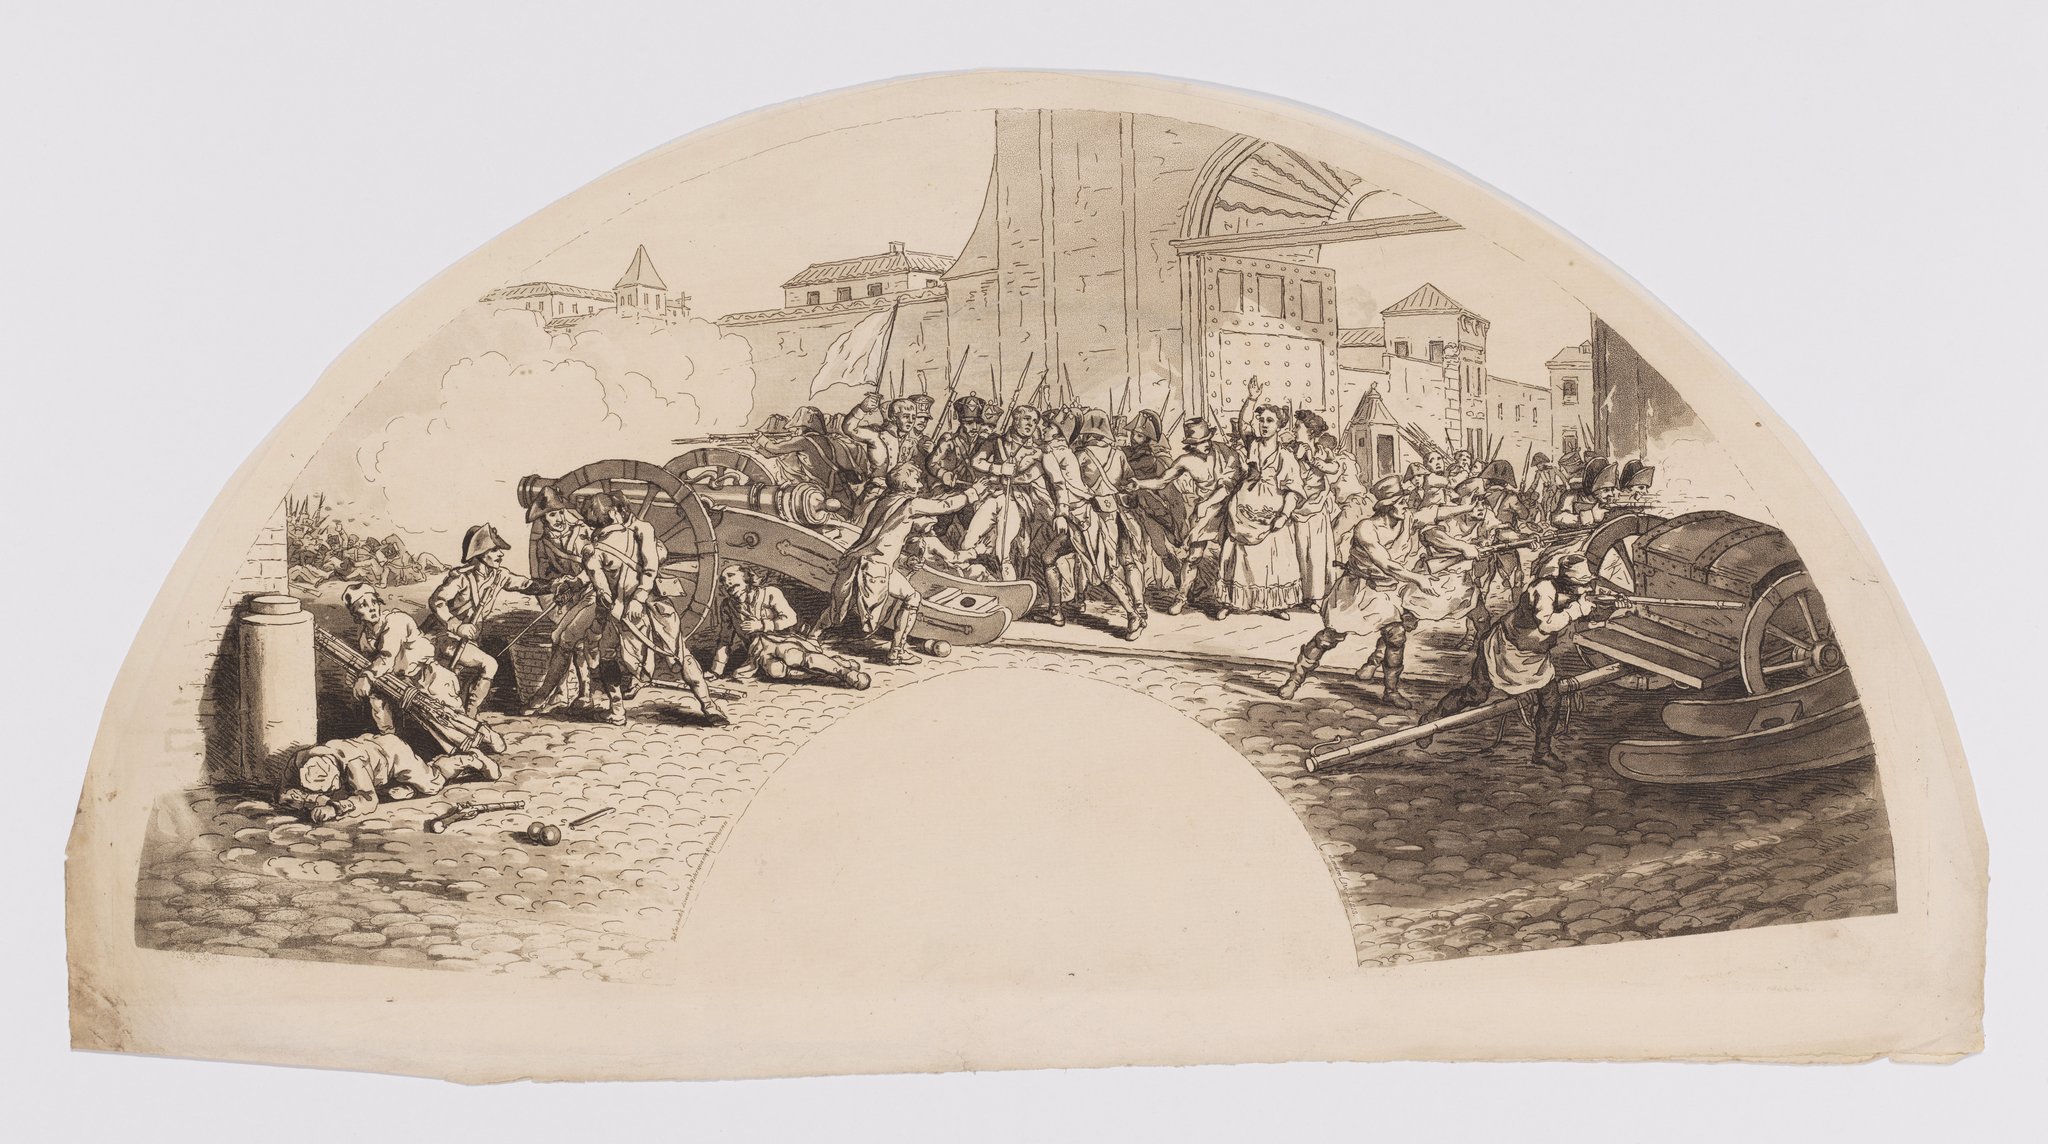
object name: print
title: Daviz and Velarde Die Defending the Parque de Artilleria (Mueren Daviz and Velarde defendiendo el Parque de Artilleria)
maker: anonymous, british, 19th century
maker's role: artist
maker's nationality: british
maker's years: 1800-1900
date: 1813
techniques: aquatint, etching